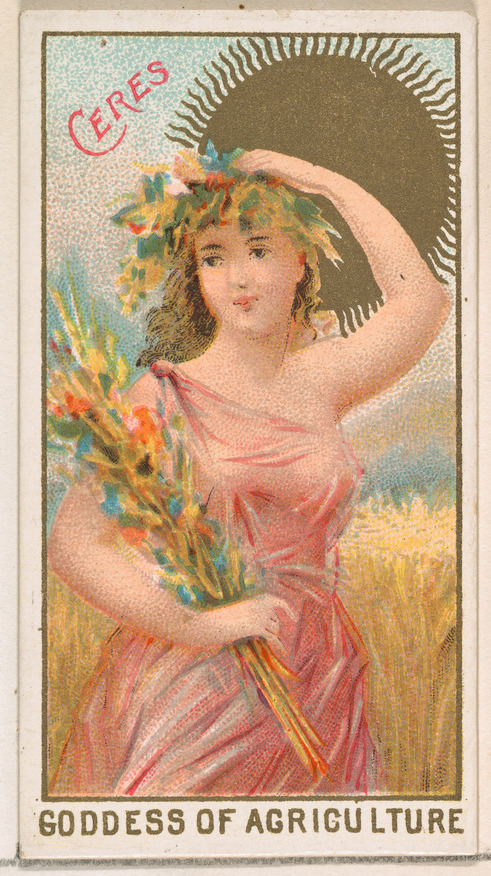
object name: print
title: Ceres, Goddess of Agriculture, from the Goddesses of the Greeks and Romans series (N188) issued by Wm. S. Kimball & Co.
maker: william s. kimball & company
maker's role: publisher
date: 1889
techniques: color lithograph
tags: ceres